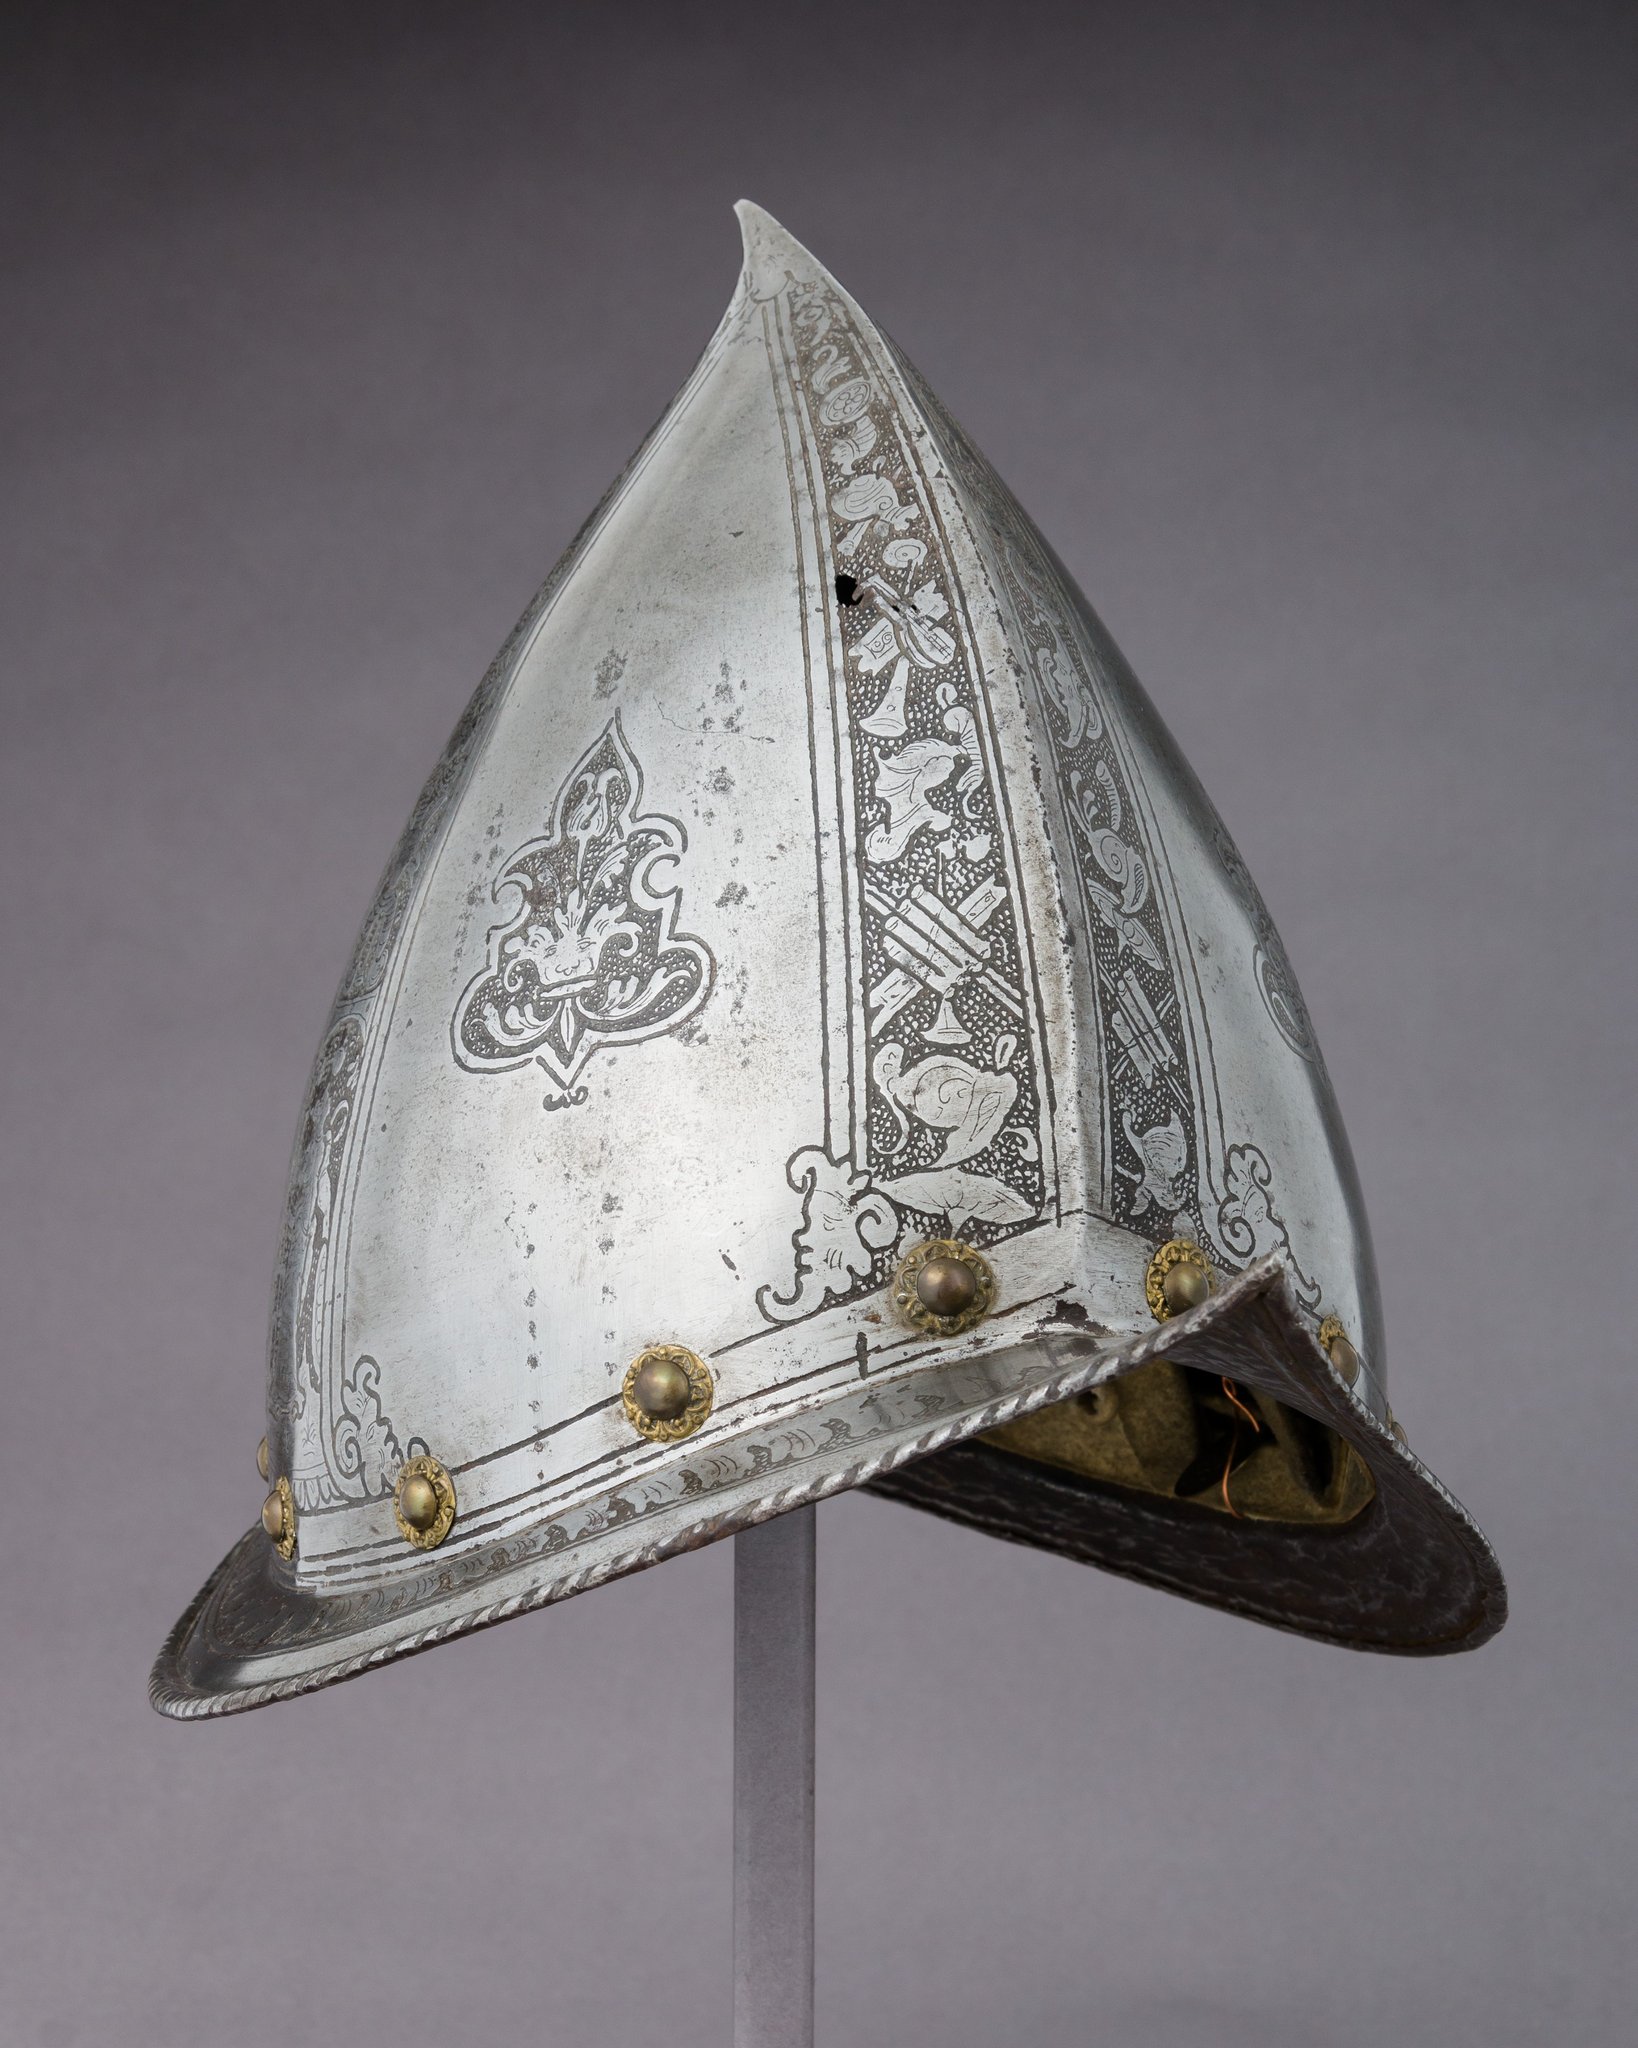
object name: morion cabasset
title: Morion-Cabasset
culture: italian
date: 1501-1600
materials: brass, leather, steel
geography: italy